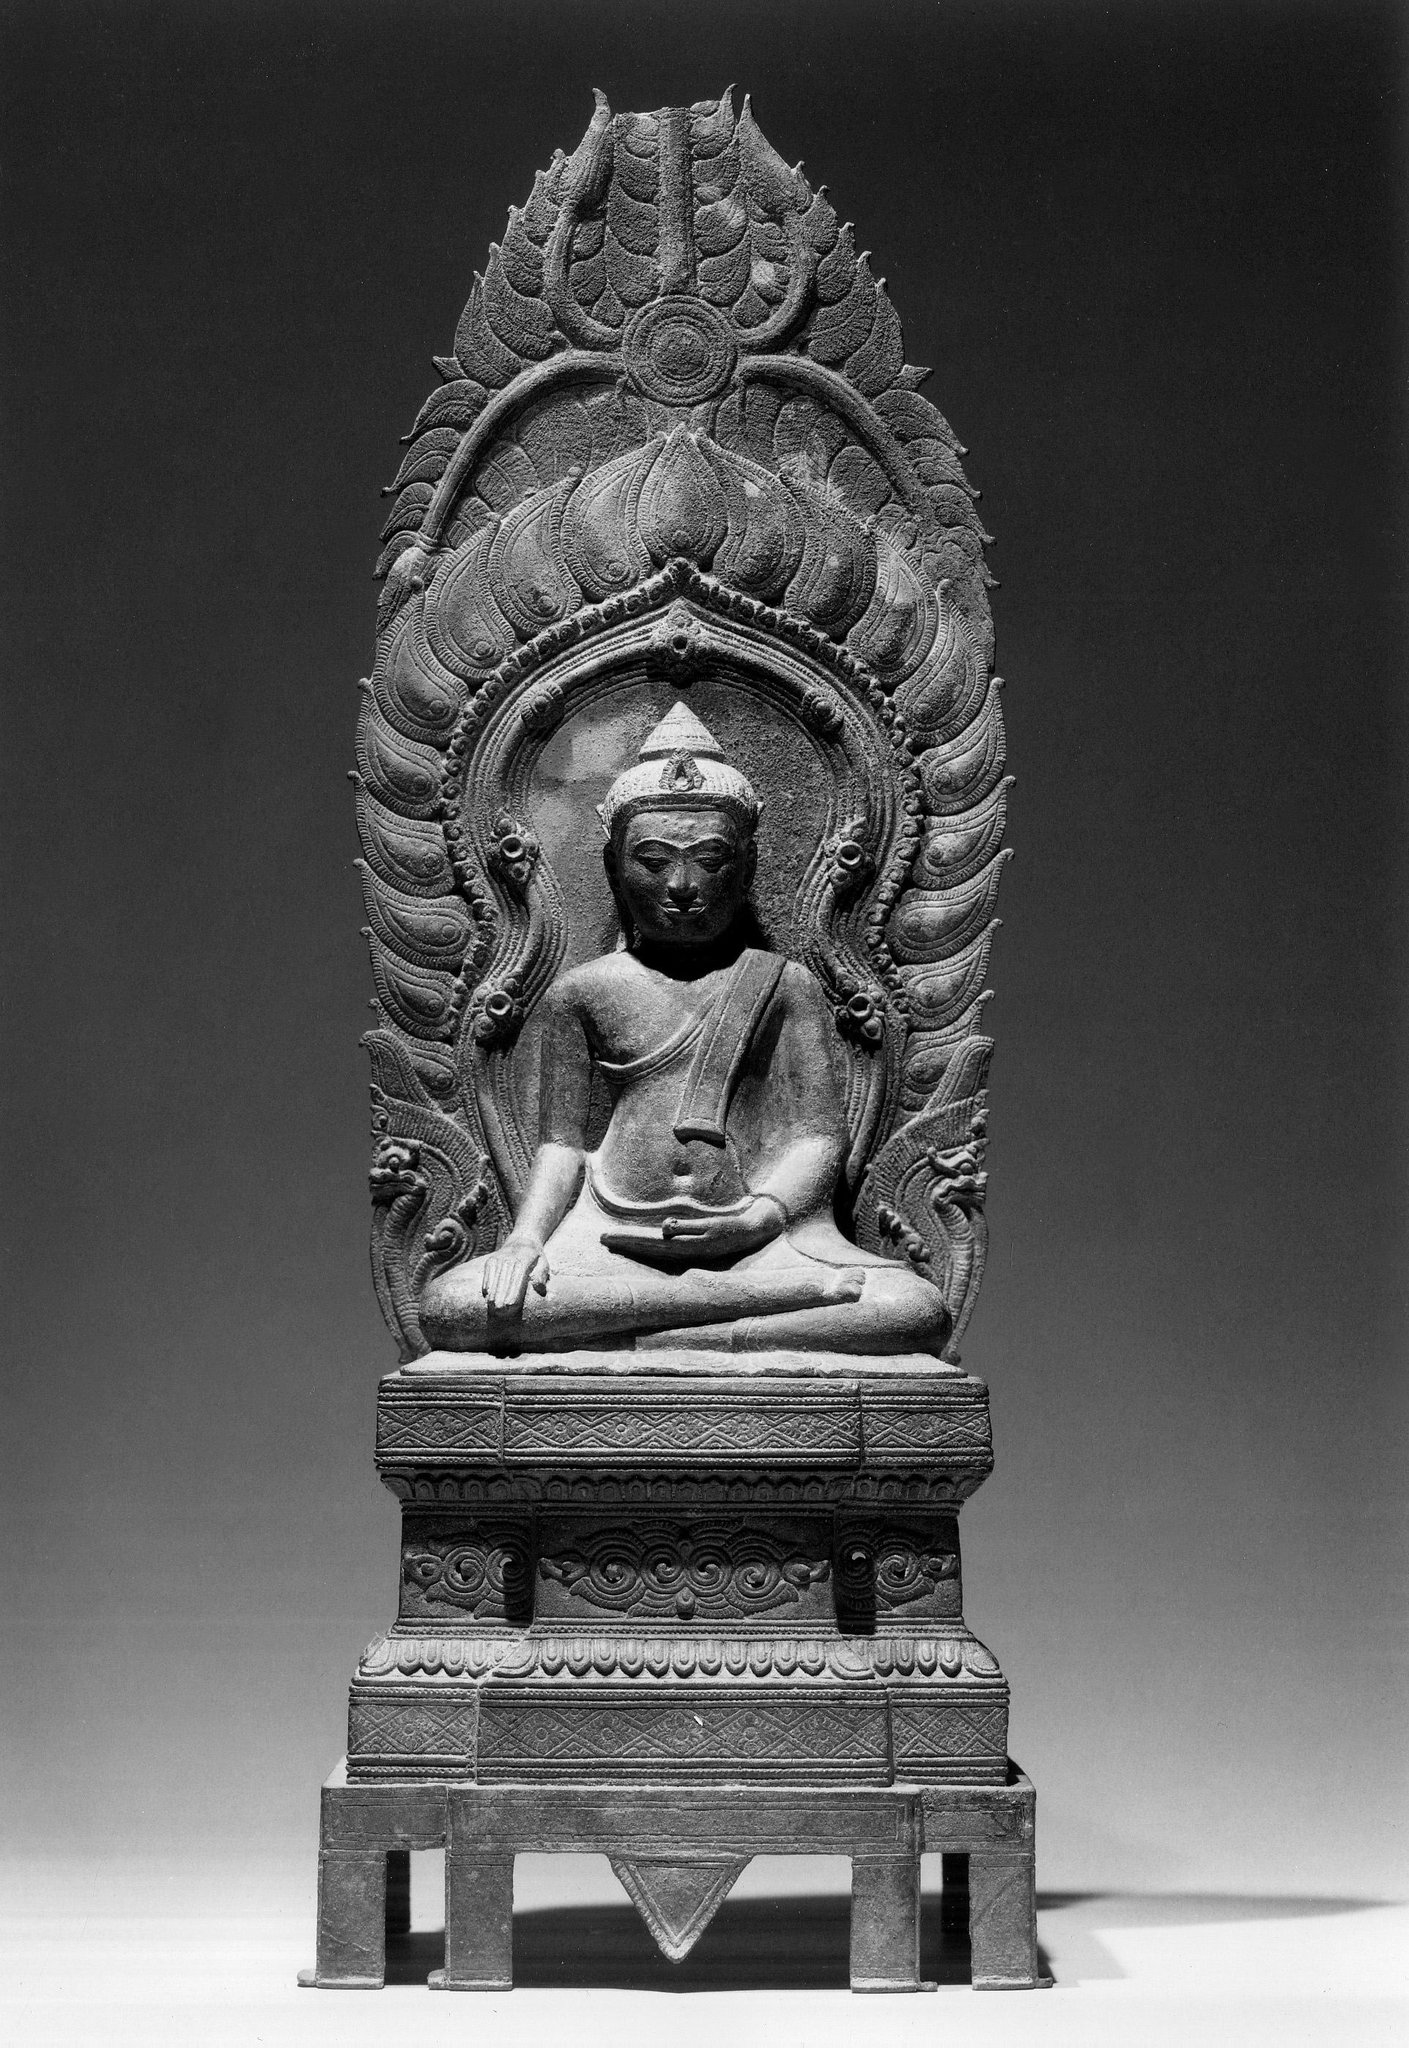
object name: shrine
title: Seated Buddha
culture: thai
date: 1201-1250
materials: bronze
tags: buddhism,buddha